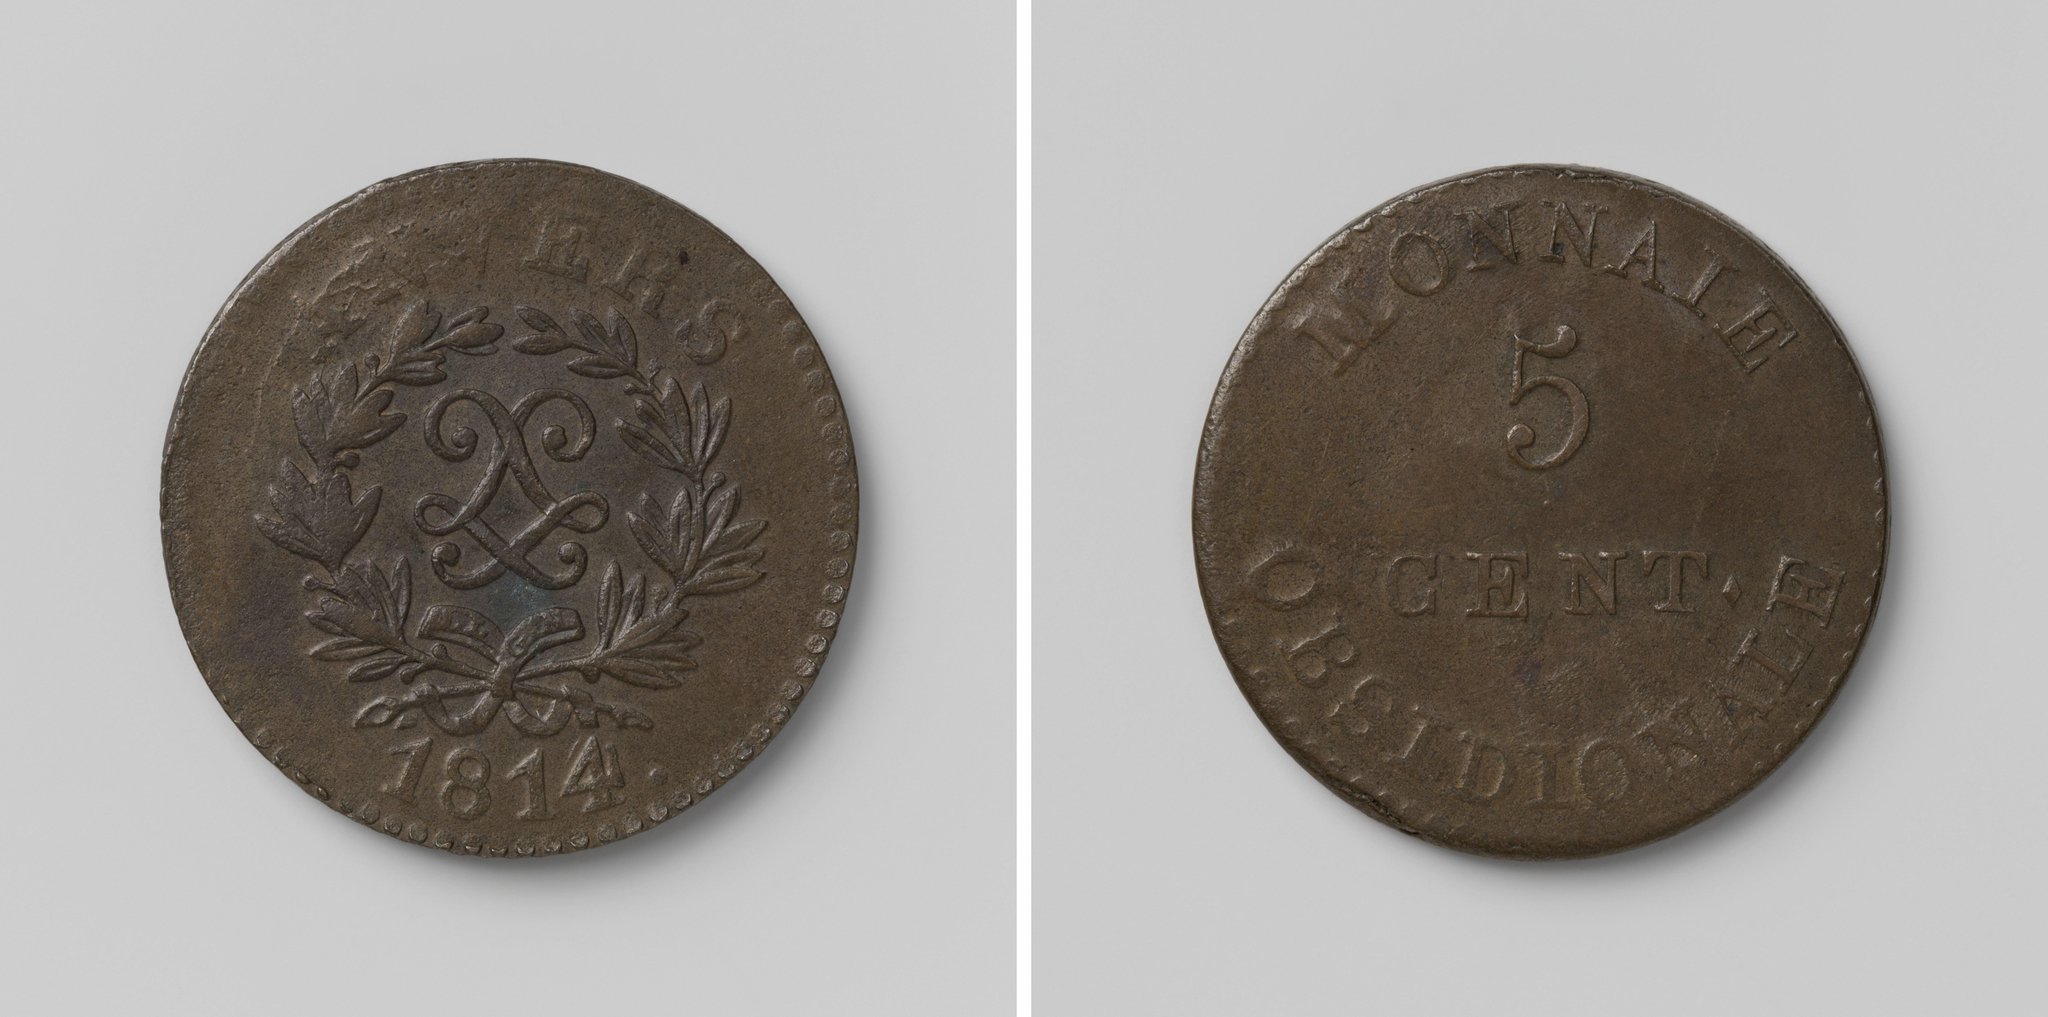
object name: vijf cent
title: Beleg van Antwerpen, noodmunt van vijf cent geslagen door Lodewijk XVIII, koning van Frankrijk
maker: jean louis gagnepain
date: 1814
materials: copper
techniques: striking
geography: antwerp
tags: paris, lodewijk xviii (koning van frankrijk), antwerp